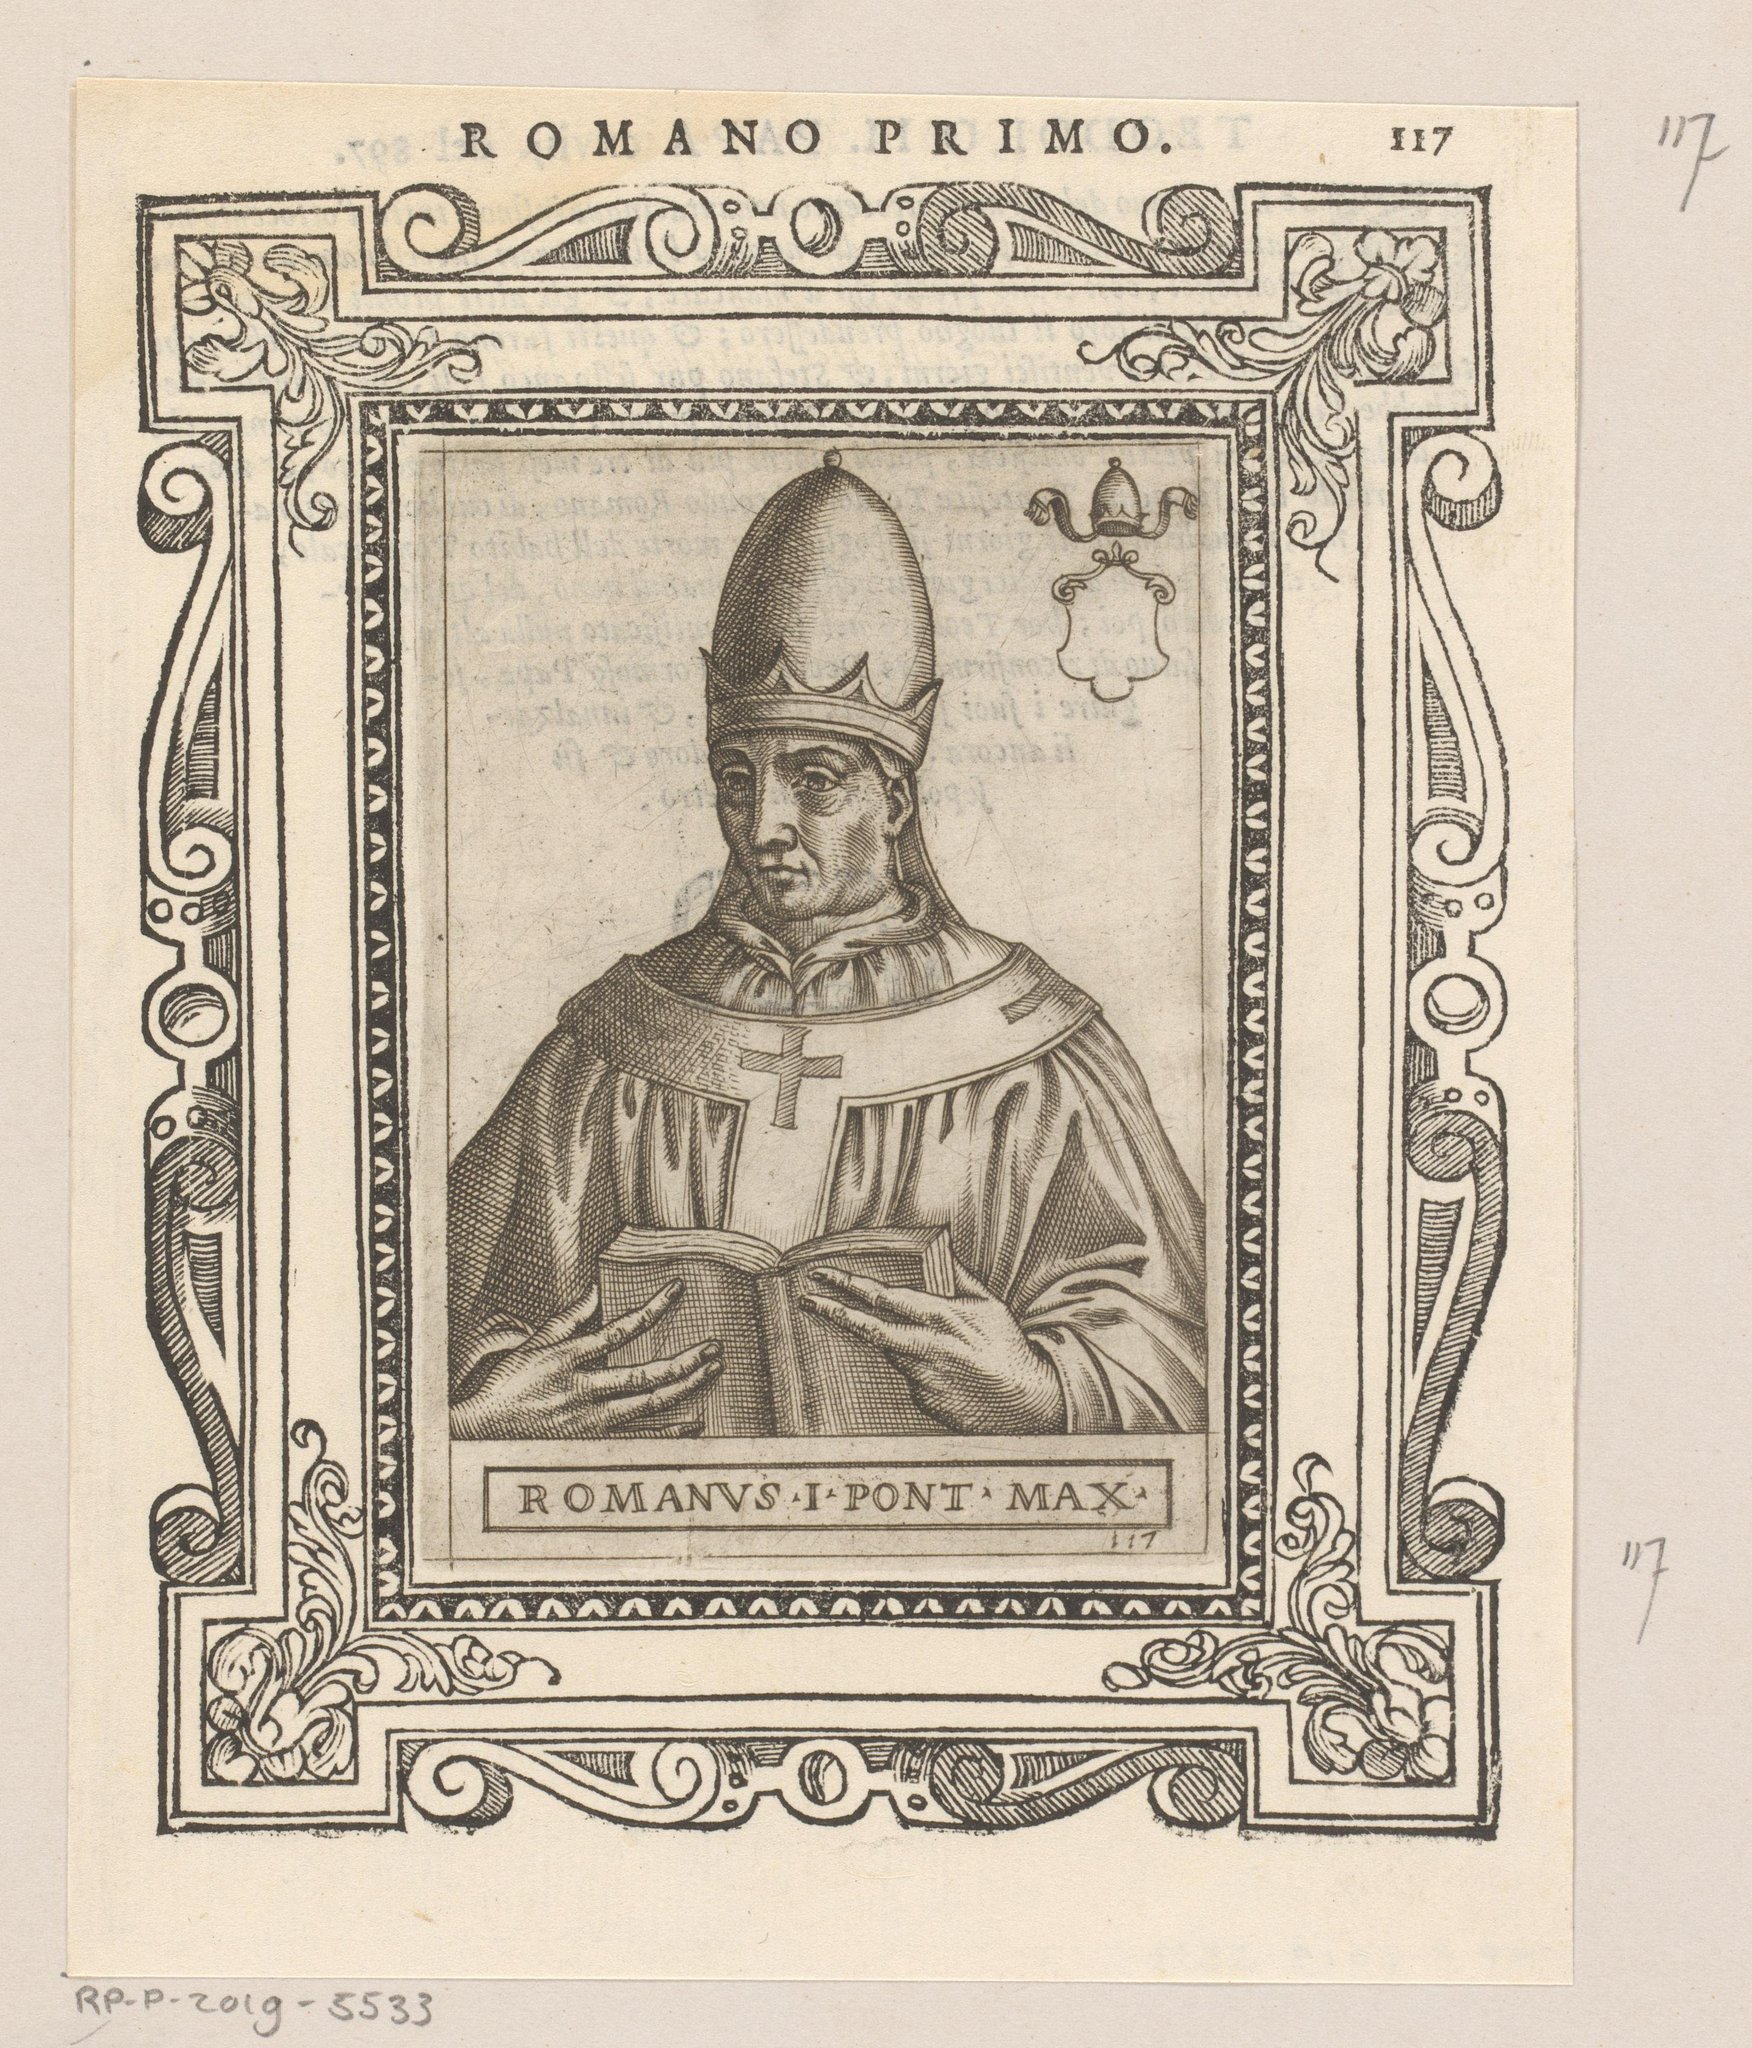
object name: print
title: Romanus I Pont Max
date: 1587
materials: paper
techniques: engraving, letterpress printing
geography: rome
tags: historical persons, pope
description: Prent uit: Ciccarelli, Antonio. Le vite de Pontefici di Antonio Ciccarelli (...). Rome: Domenico Basa, 1587. Prent voor het eerst verschenen in: Cavalieri, Giovanni Battista de'. Pontificum romanorum effigies (...). Rome: Domenico Basa en Francesco Zanetti, 1580. Prent ook gebruikt in latere publicaties.